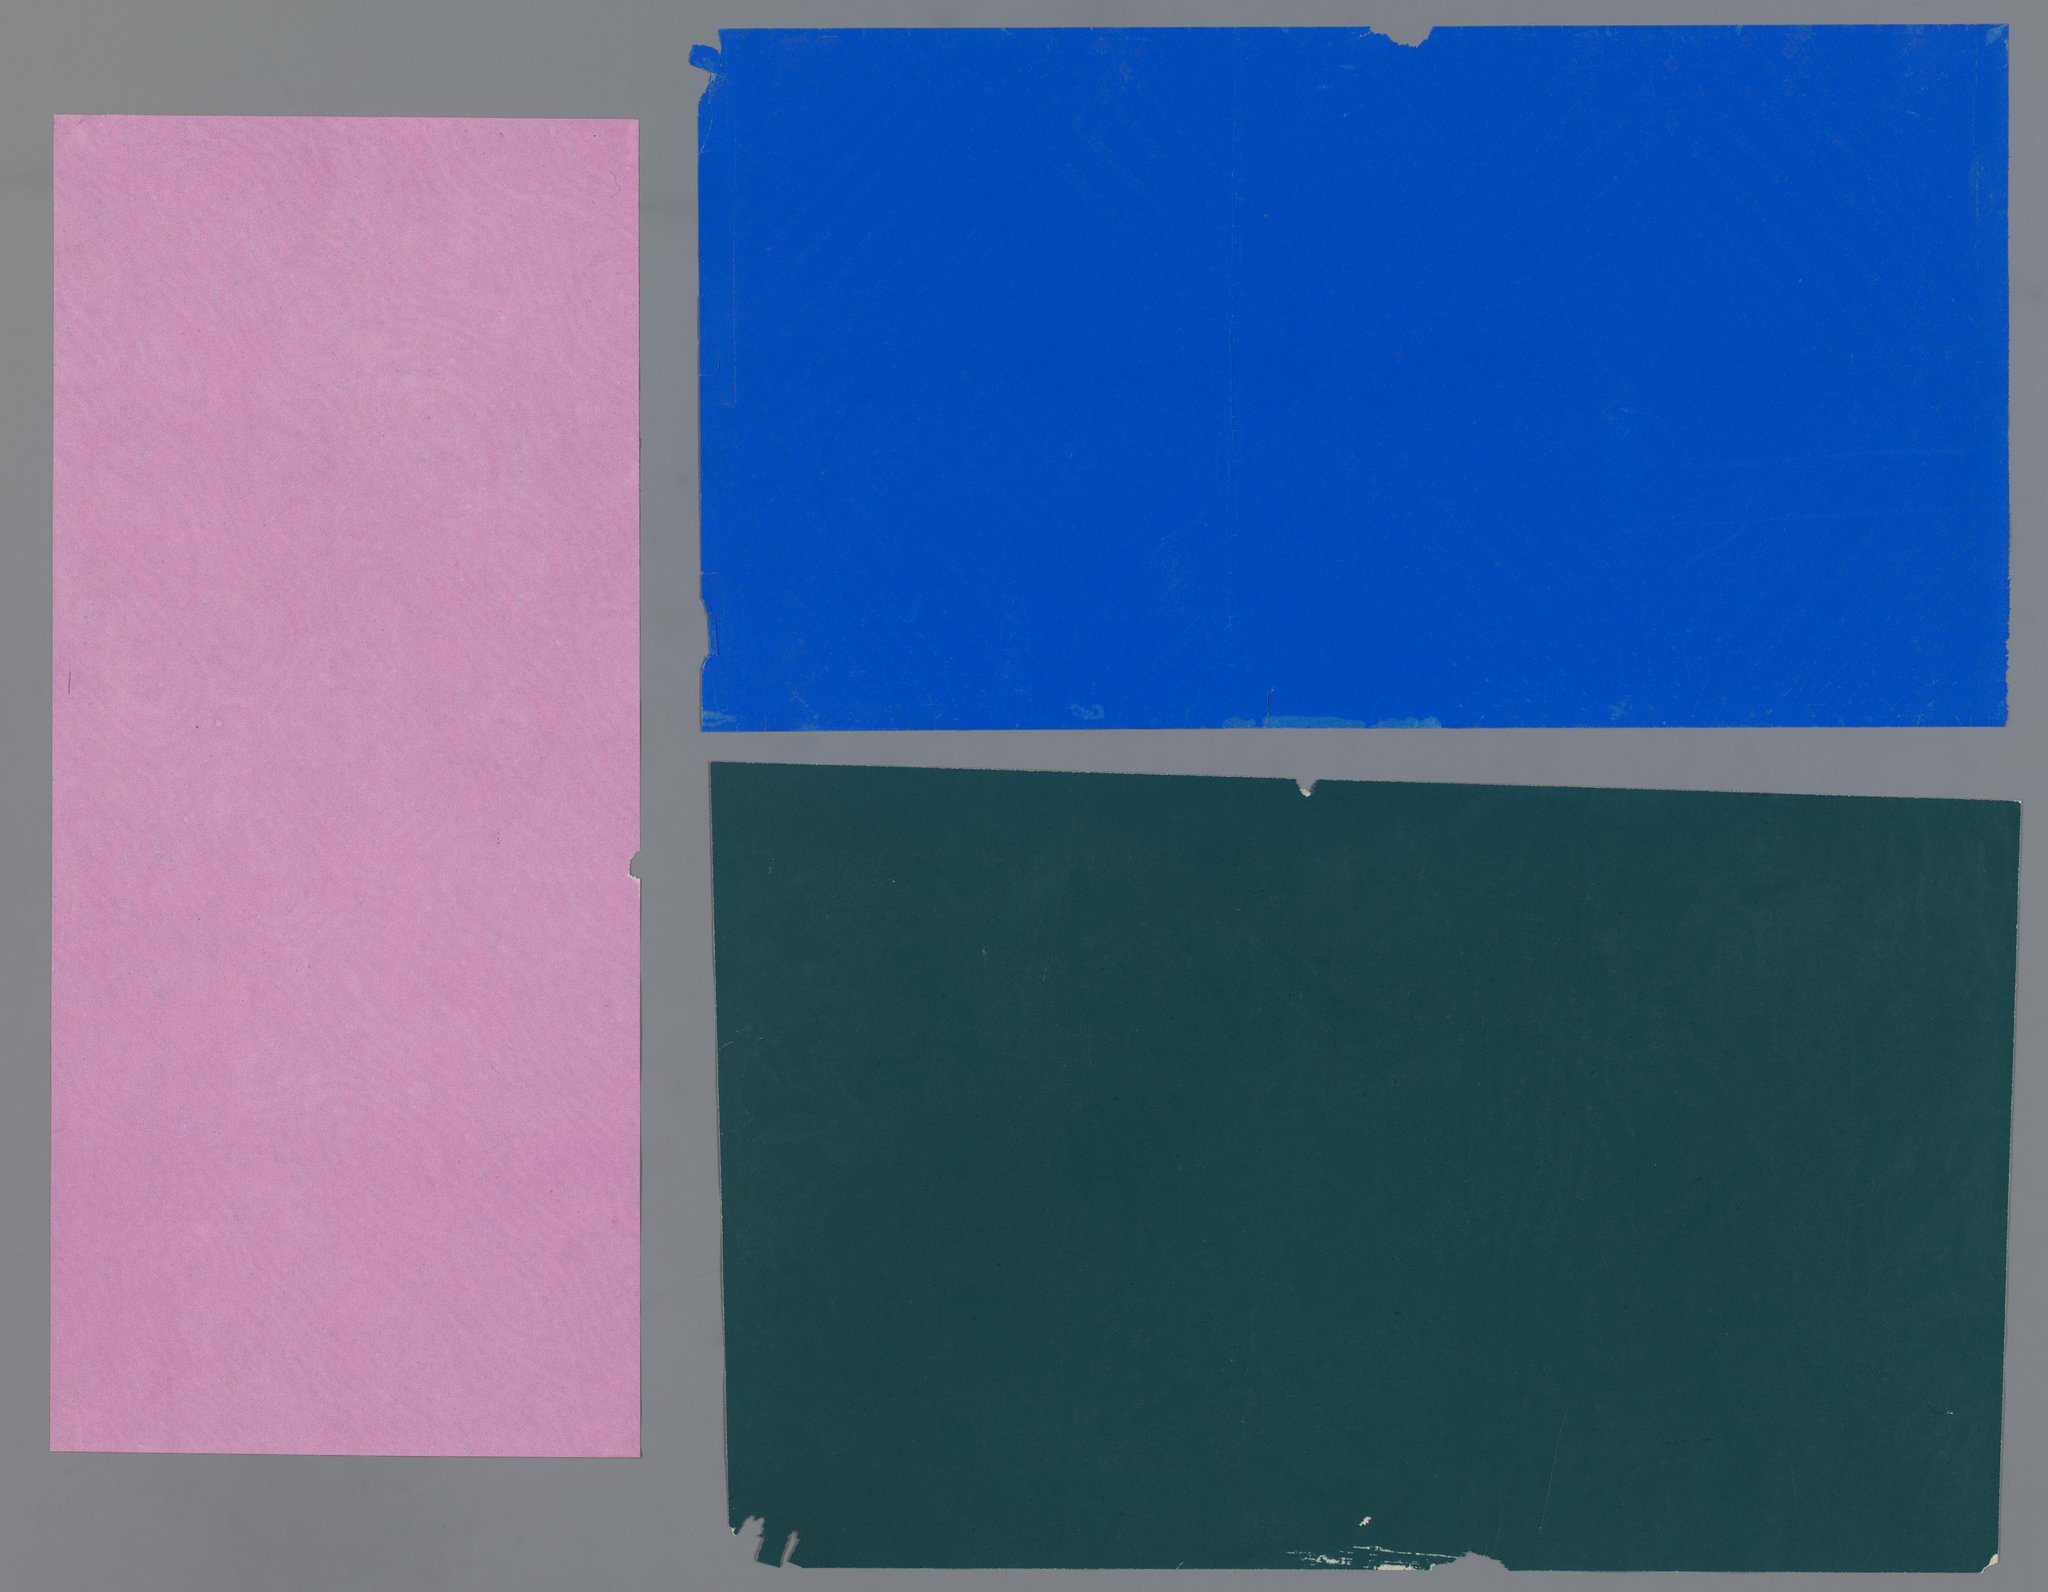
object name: decorated paper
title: Omslag met bladen gekleurd papier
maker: Anonymous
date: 1900-1970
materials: paper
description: Omslag met 40 losse bladen effen gekleurd of geverfd papier. Deze niet-Japanse bladen papier zijn in 1984 bij het opzetten van de Japanse sjablonen (katagami) in verwijderd van achter de sjablonen en in deze map verzameld.